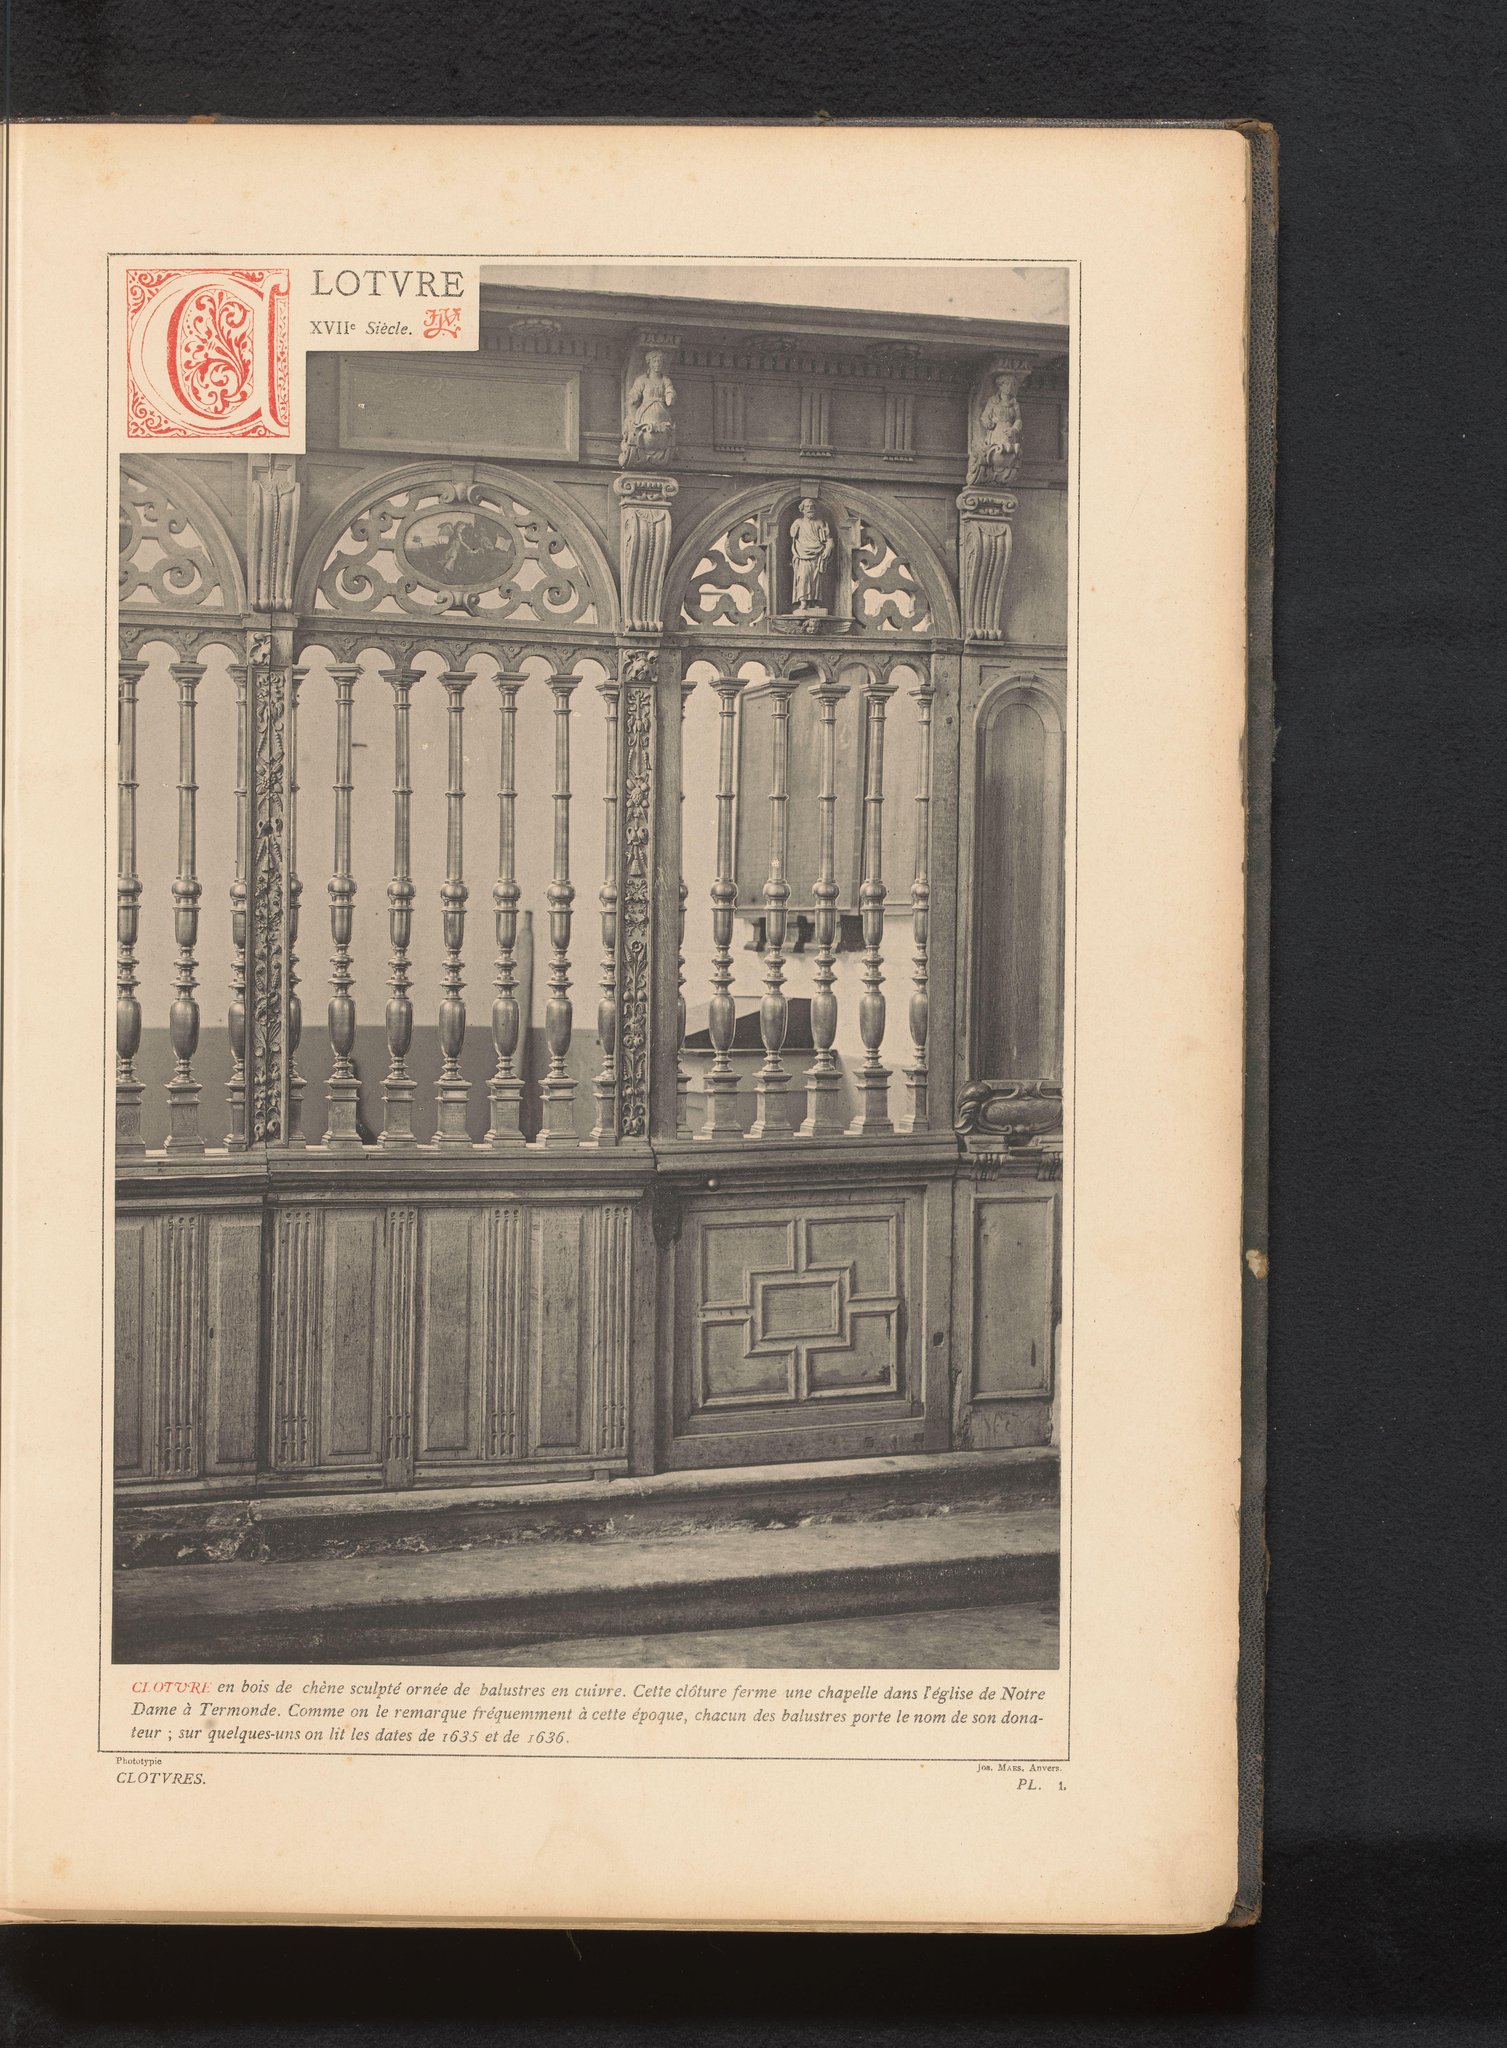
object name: photomechanical print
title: Gedecoreerd hek rond een kapel in de Onze-Lieve-Vrouwekerk te Dendermonde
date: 1881-1889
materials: paper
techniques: photograph, photolithography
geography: antwerp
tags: interior of church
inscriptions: inscription: ‘COTURES. PL. 1.’, monogram: ‘JJvY’, inscription: ‘CLOTURE en bois (...)’